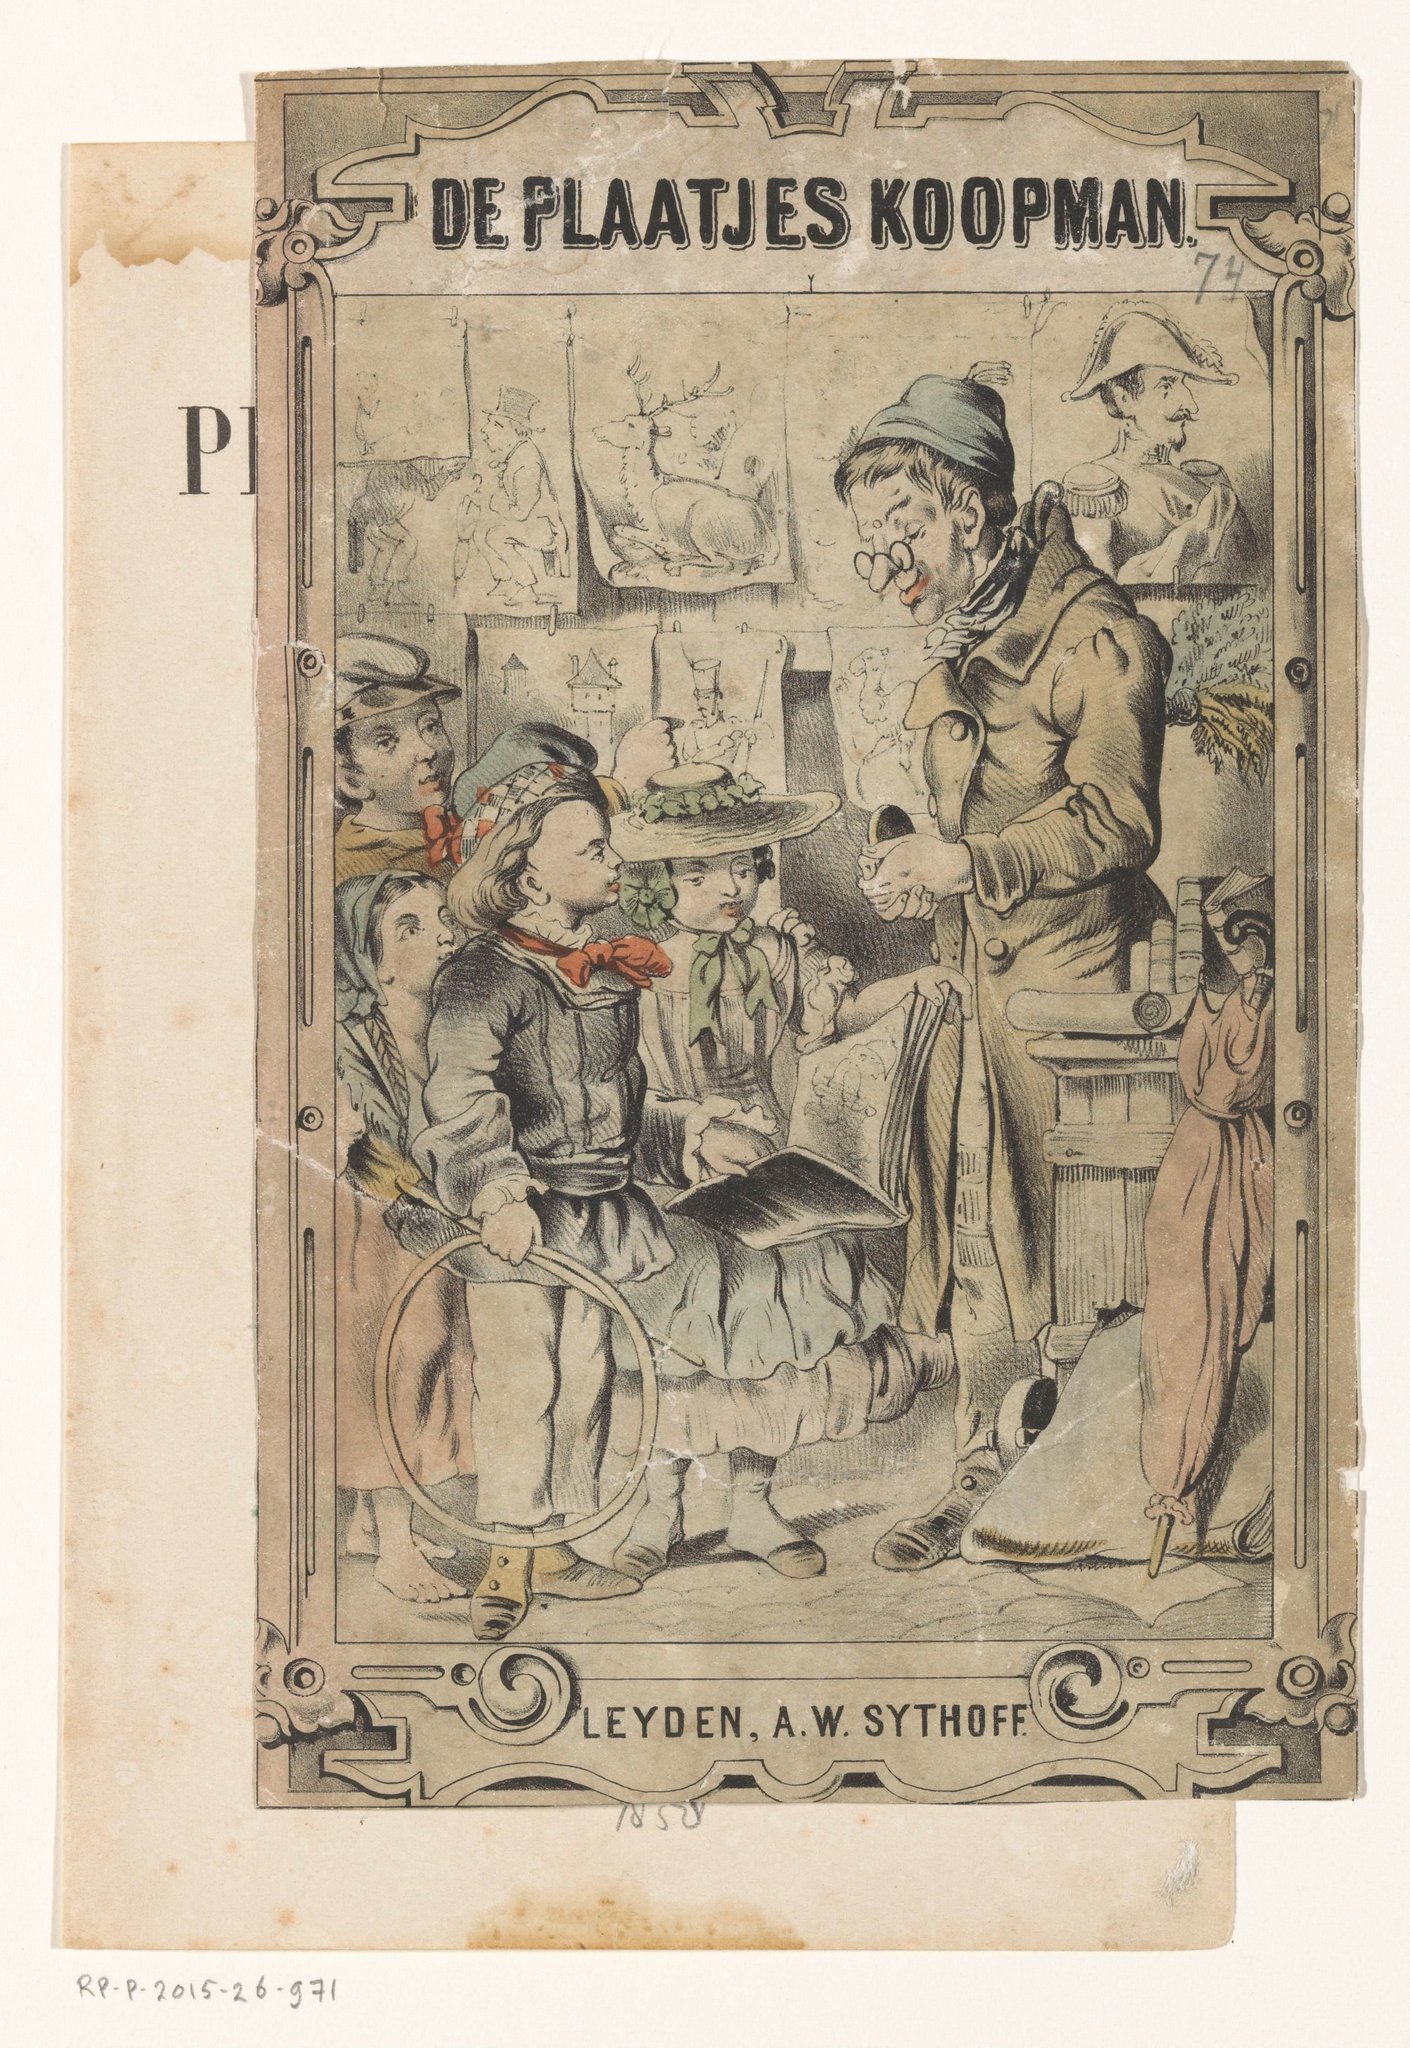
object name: print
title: Vier kinderen bij een prenthandelaar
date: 1858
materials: paper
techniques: hand coloring, lithograph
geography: leiden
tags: print, e.g.: engraving, etching, lithograph, street-trader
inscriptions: collector's mark: Lugt 2228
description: Gebruikt als omslag voor: De plaatjes koopman. Platen met bijschriften voor de lieve jeugd. Leiden: A.W. Sijthoff, [1858]. De titelpagina van dit boek wordt bij de prent bewaard. De prenten in dit boek zijn kopieën van illustraties uit een eerdere editie: Hartung, Tuisca. Le marchand d'images. Dresden: C.C. Meinhold, [1856].